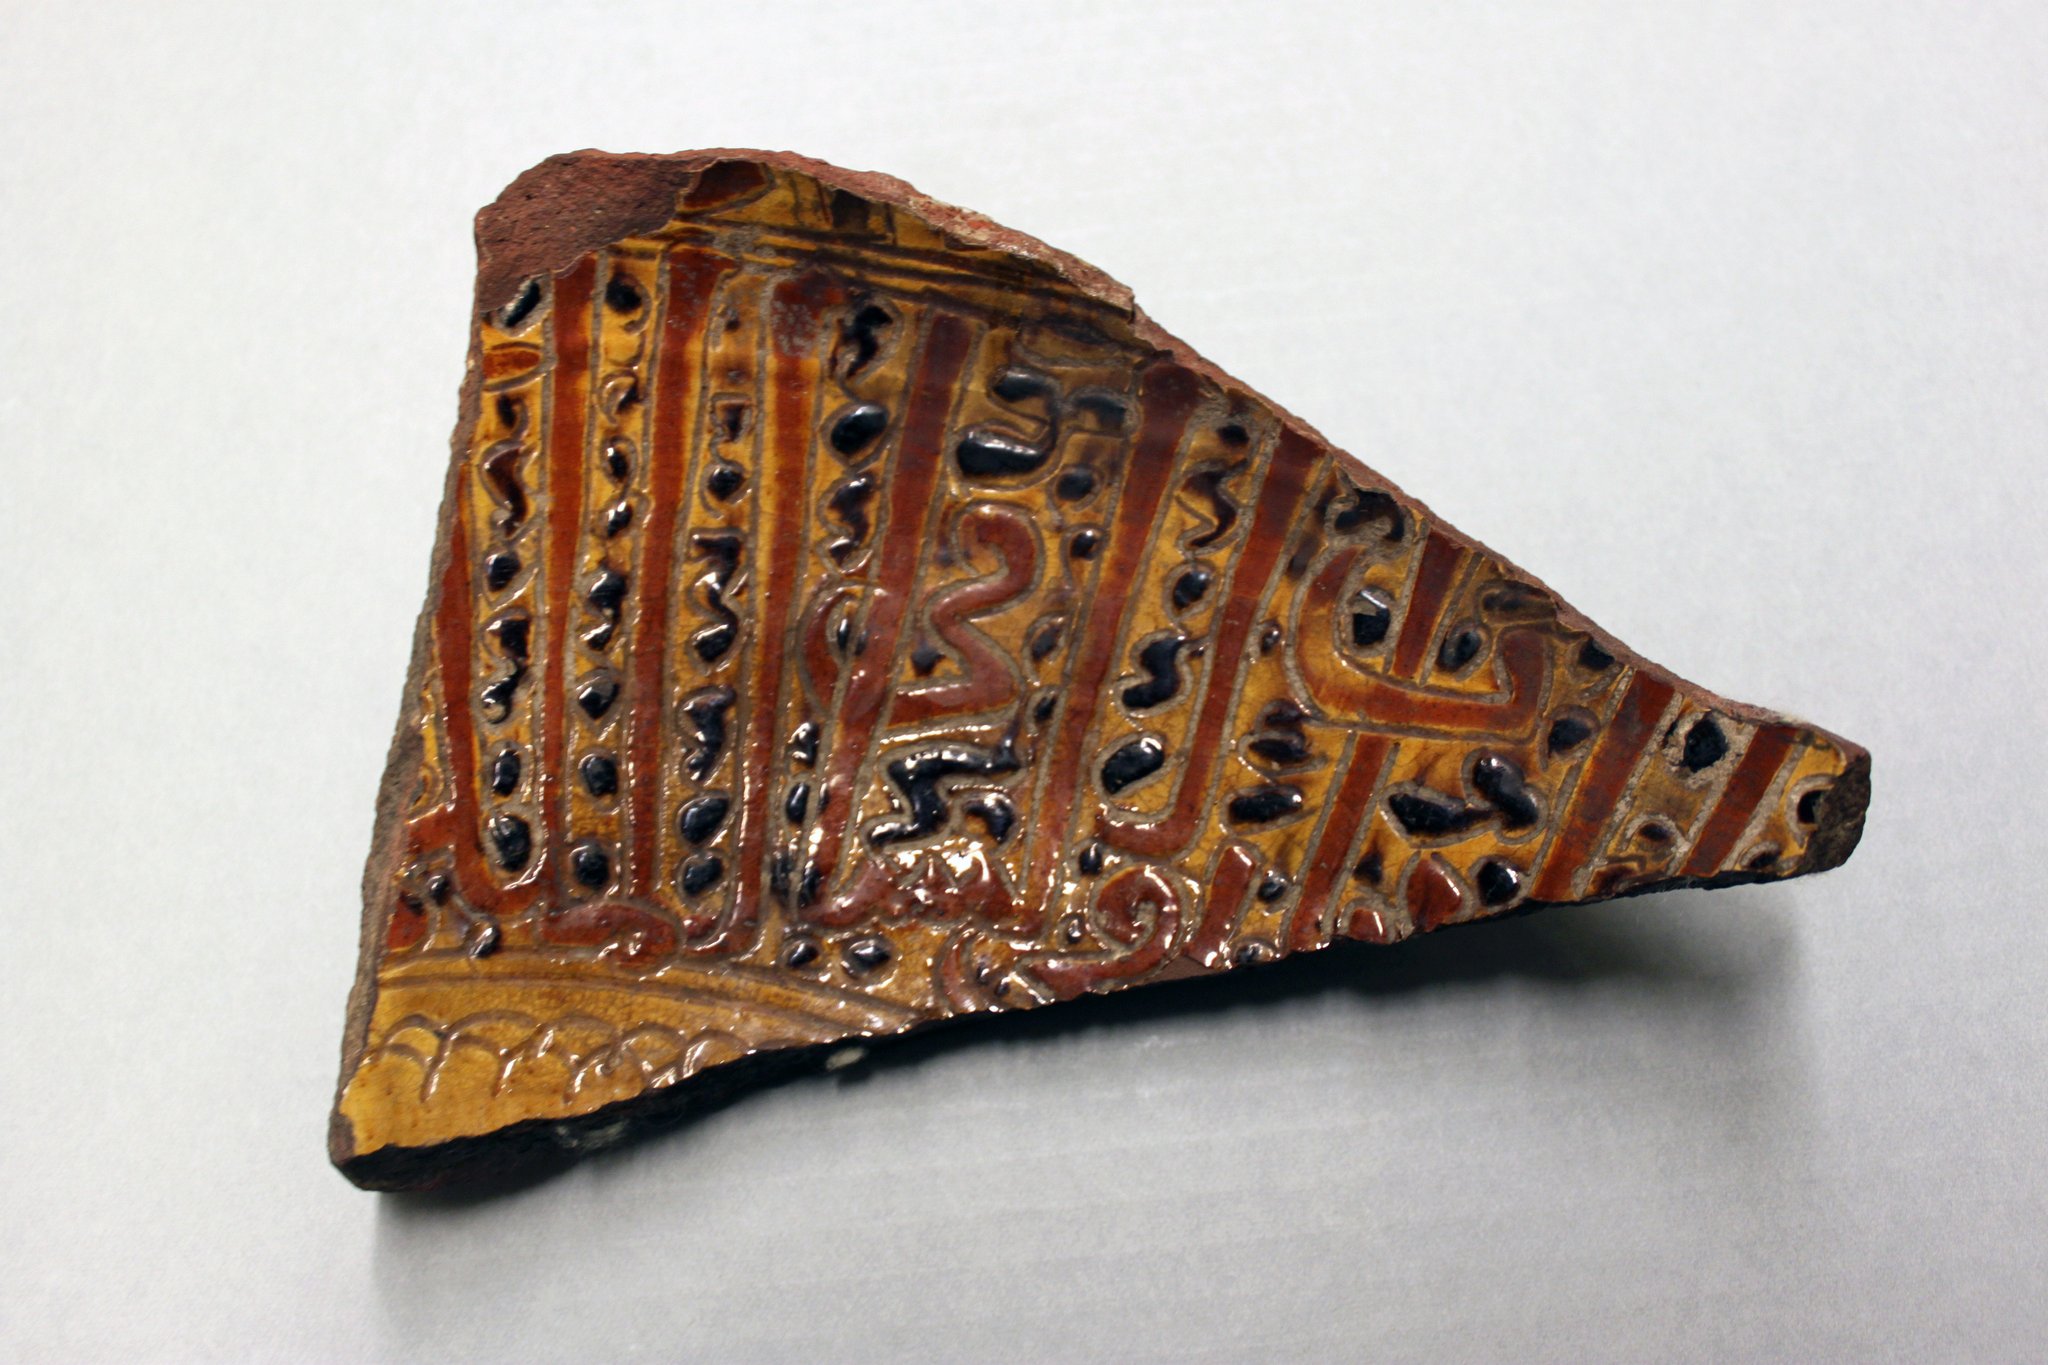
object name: fragment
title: Ceramic Fragment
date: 1301-1500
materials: earthenware, glaze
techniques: coloring, incising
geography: egypt